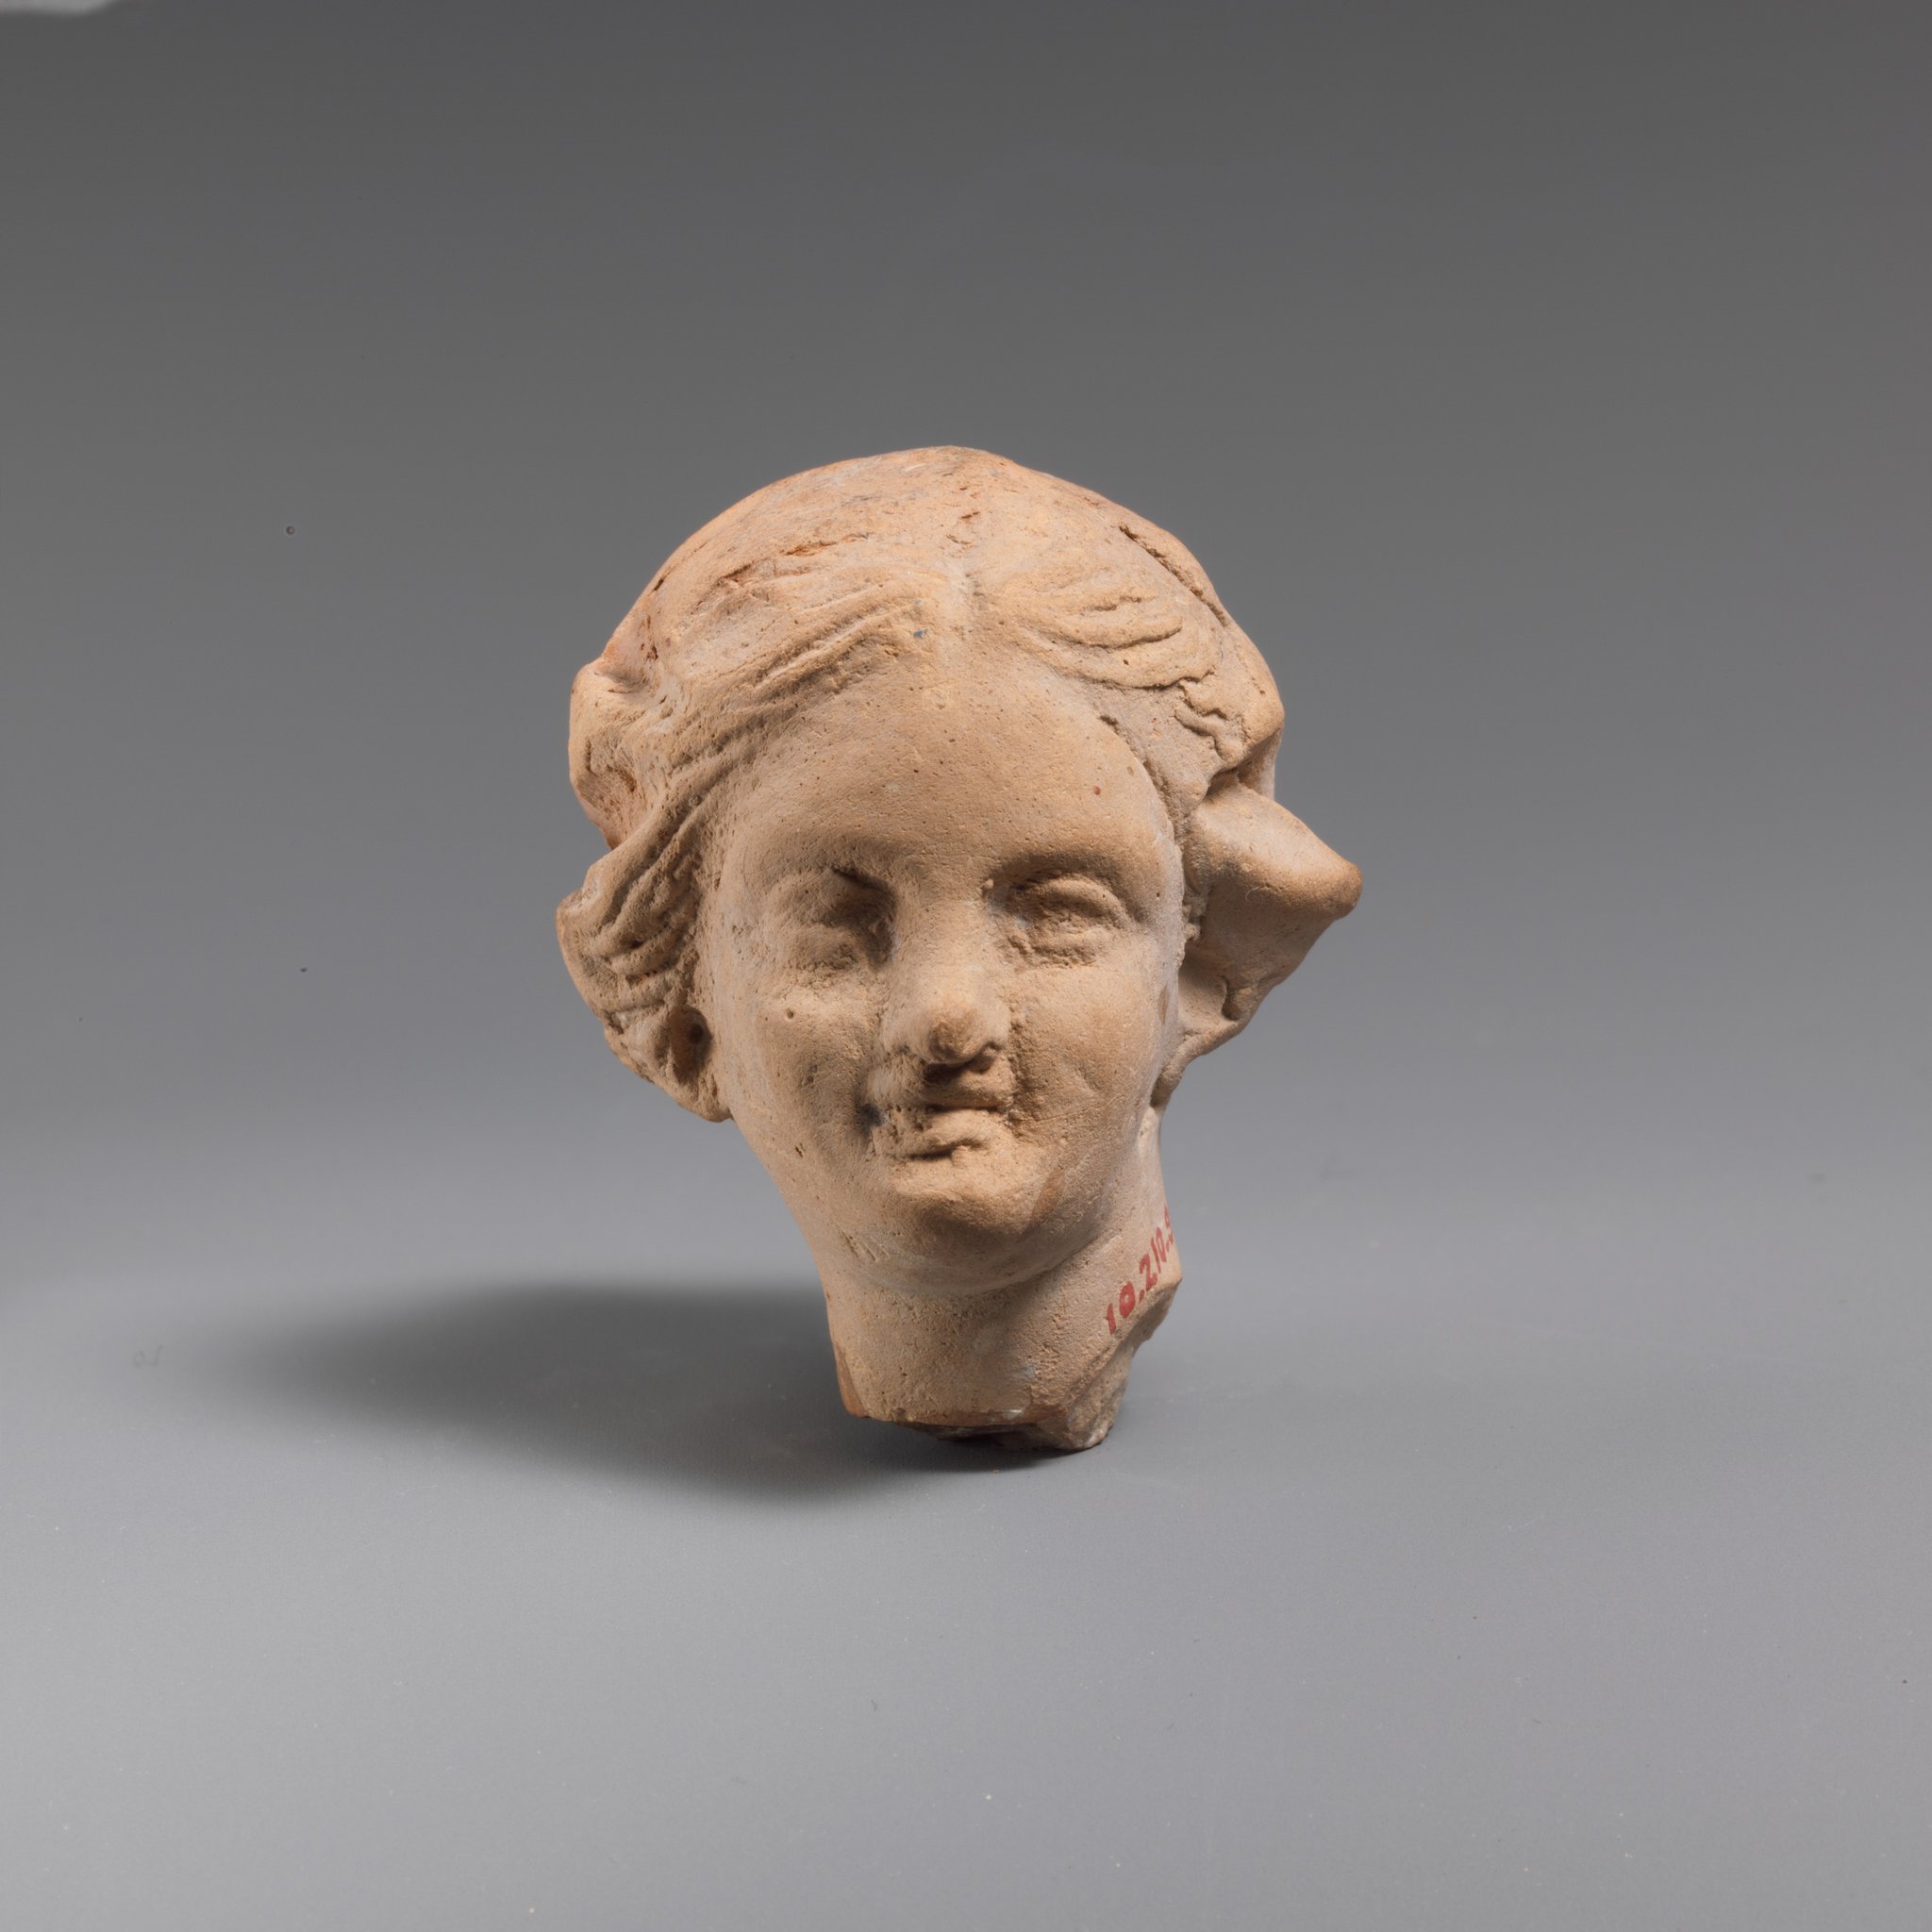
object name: head of a woman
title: Terracotta head of a young woman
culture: greek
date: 300-101 BCE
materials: terracotta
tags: heads,women